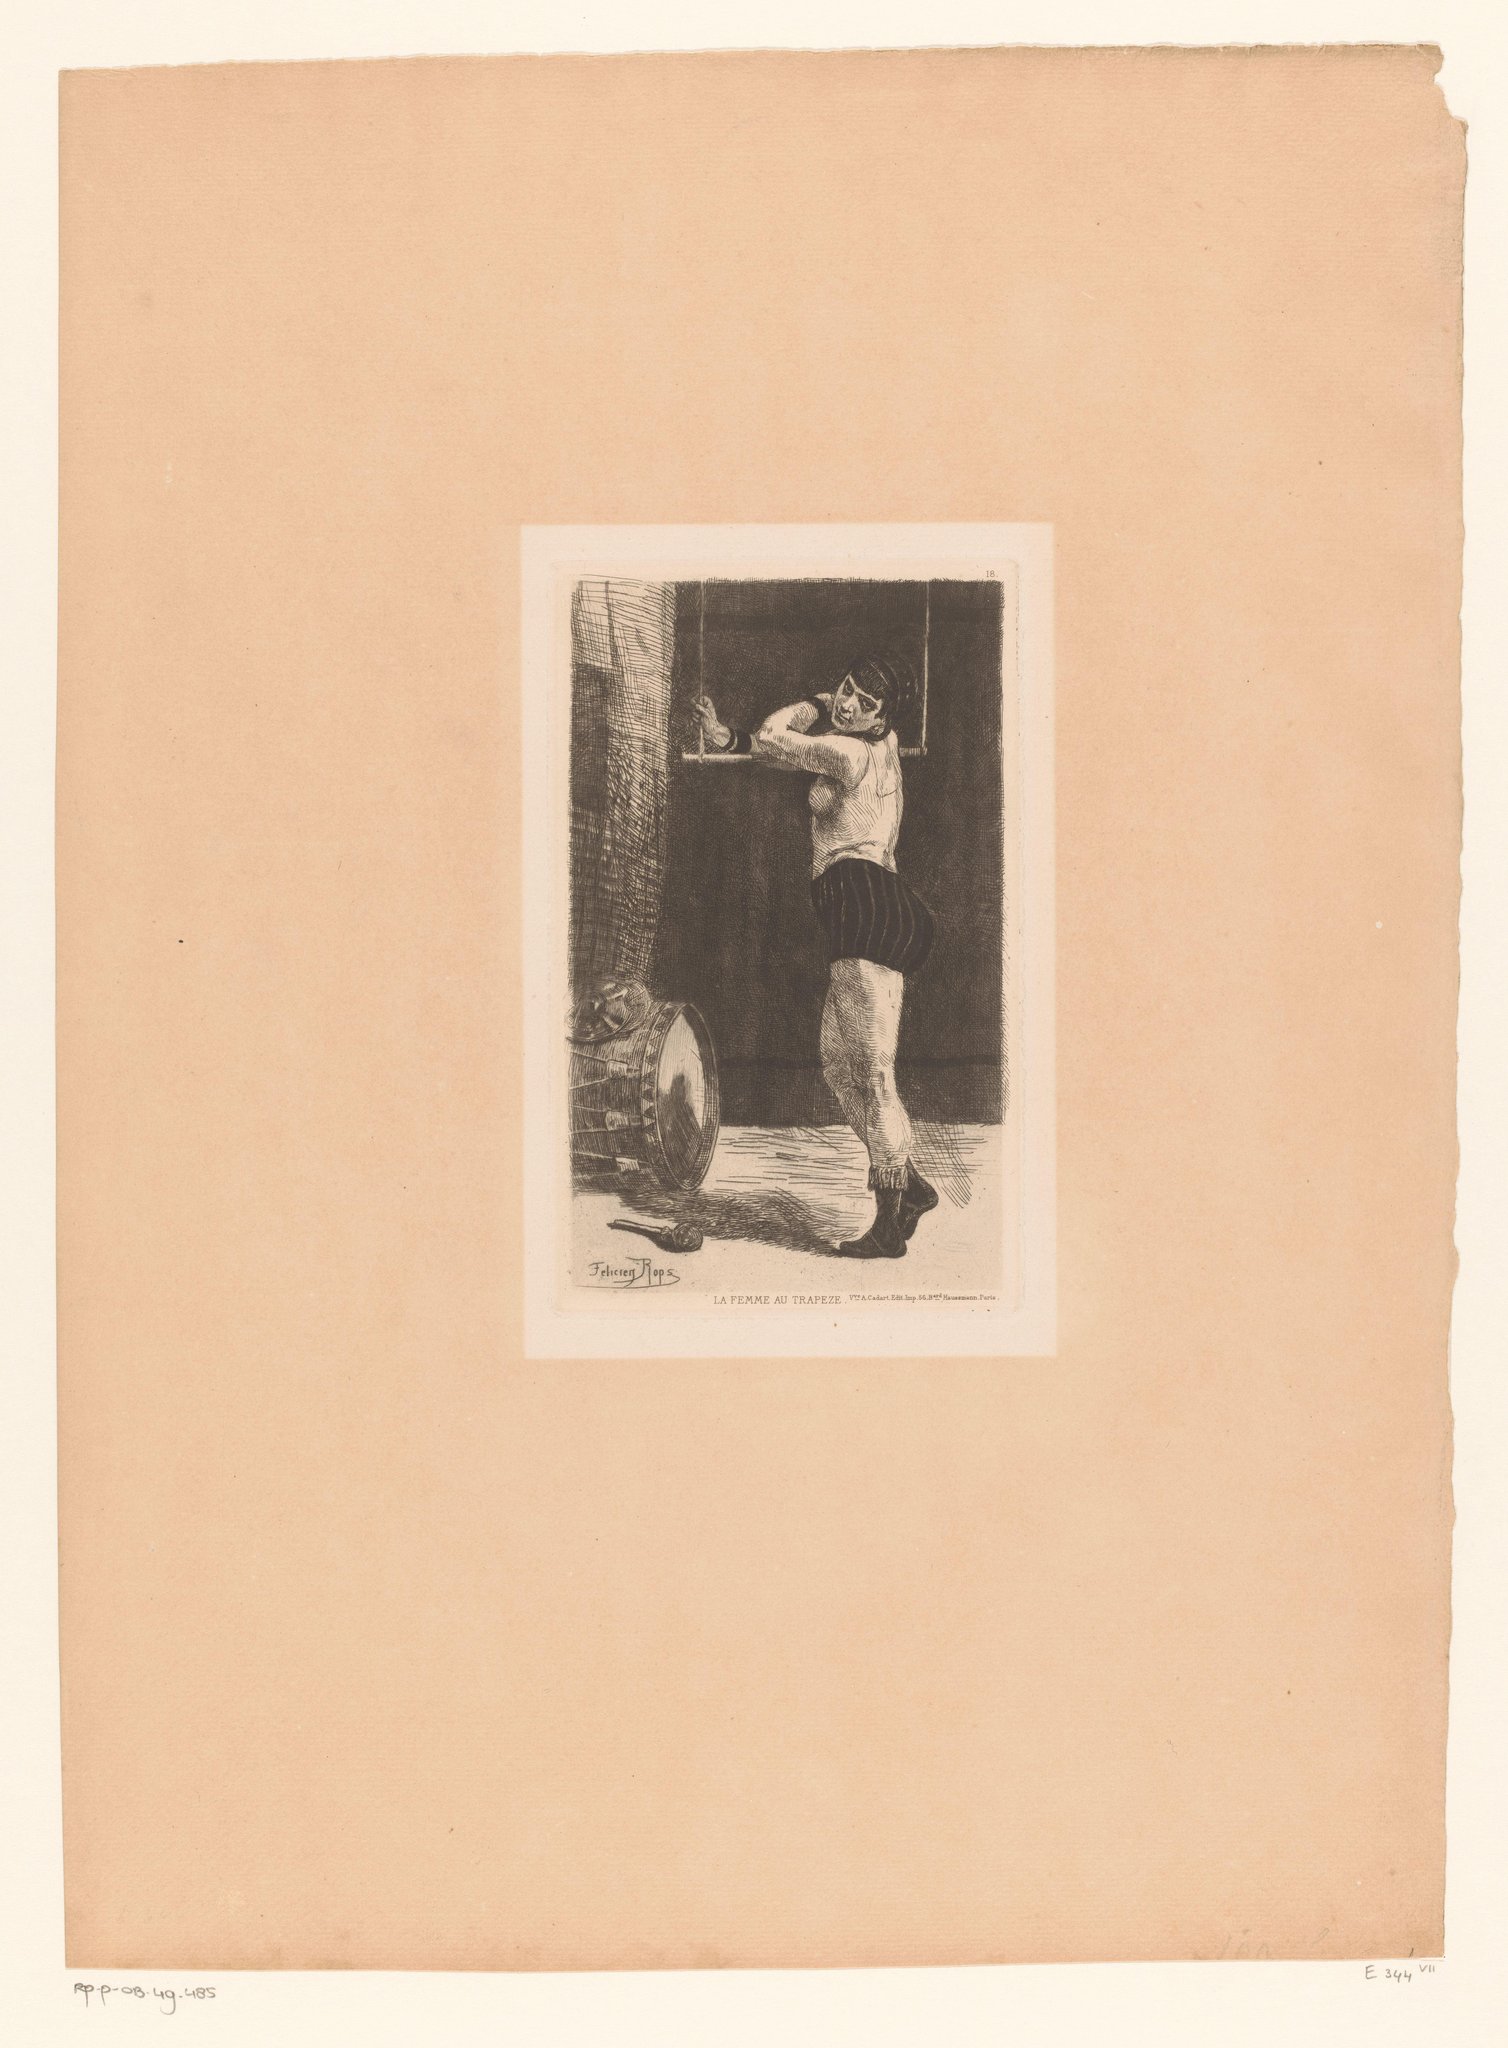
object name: print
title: Vrouwelijke circusartiest leunt op een trapeze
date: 1880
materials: paper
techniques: drypoint, etching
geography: paris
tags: trapeze acrobat, drum (musical instrument)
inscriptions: collector's mark: Lugt 2228